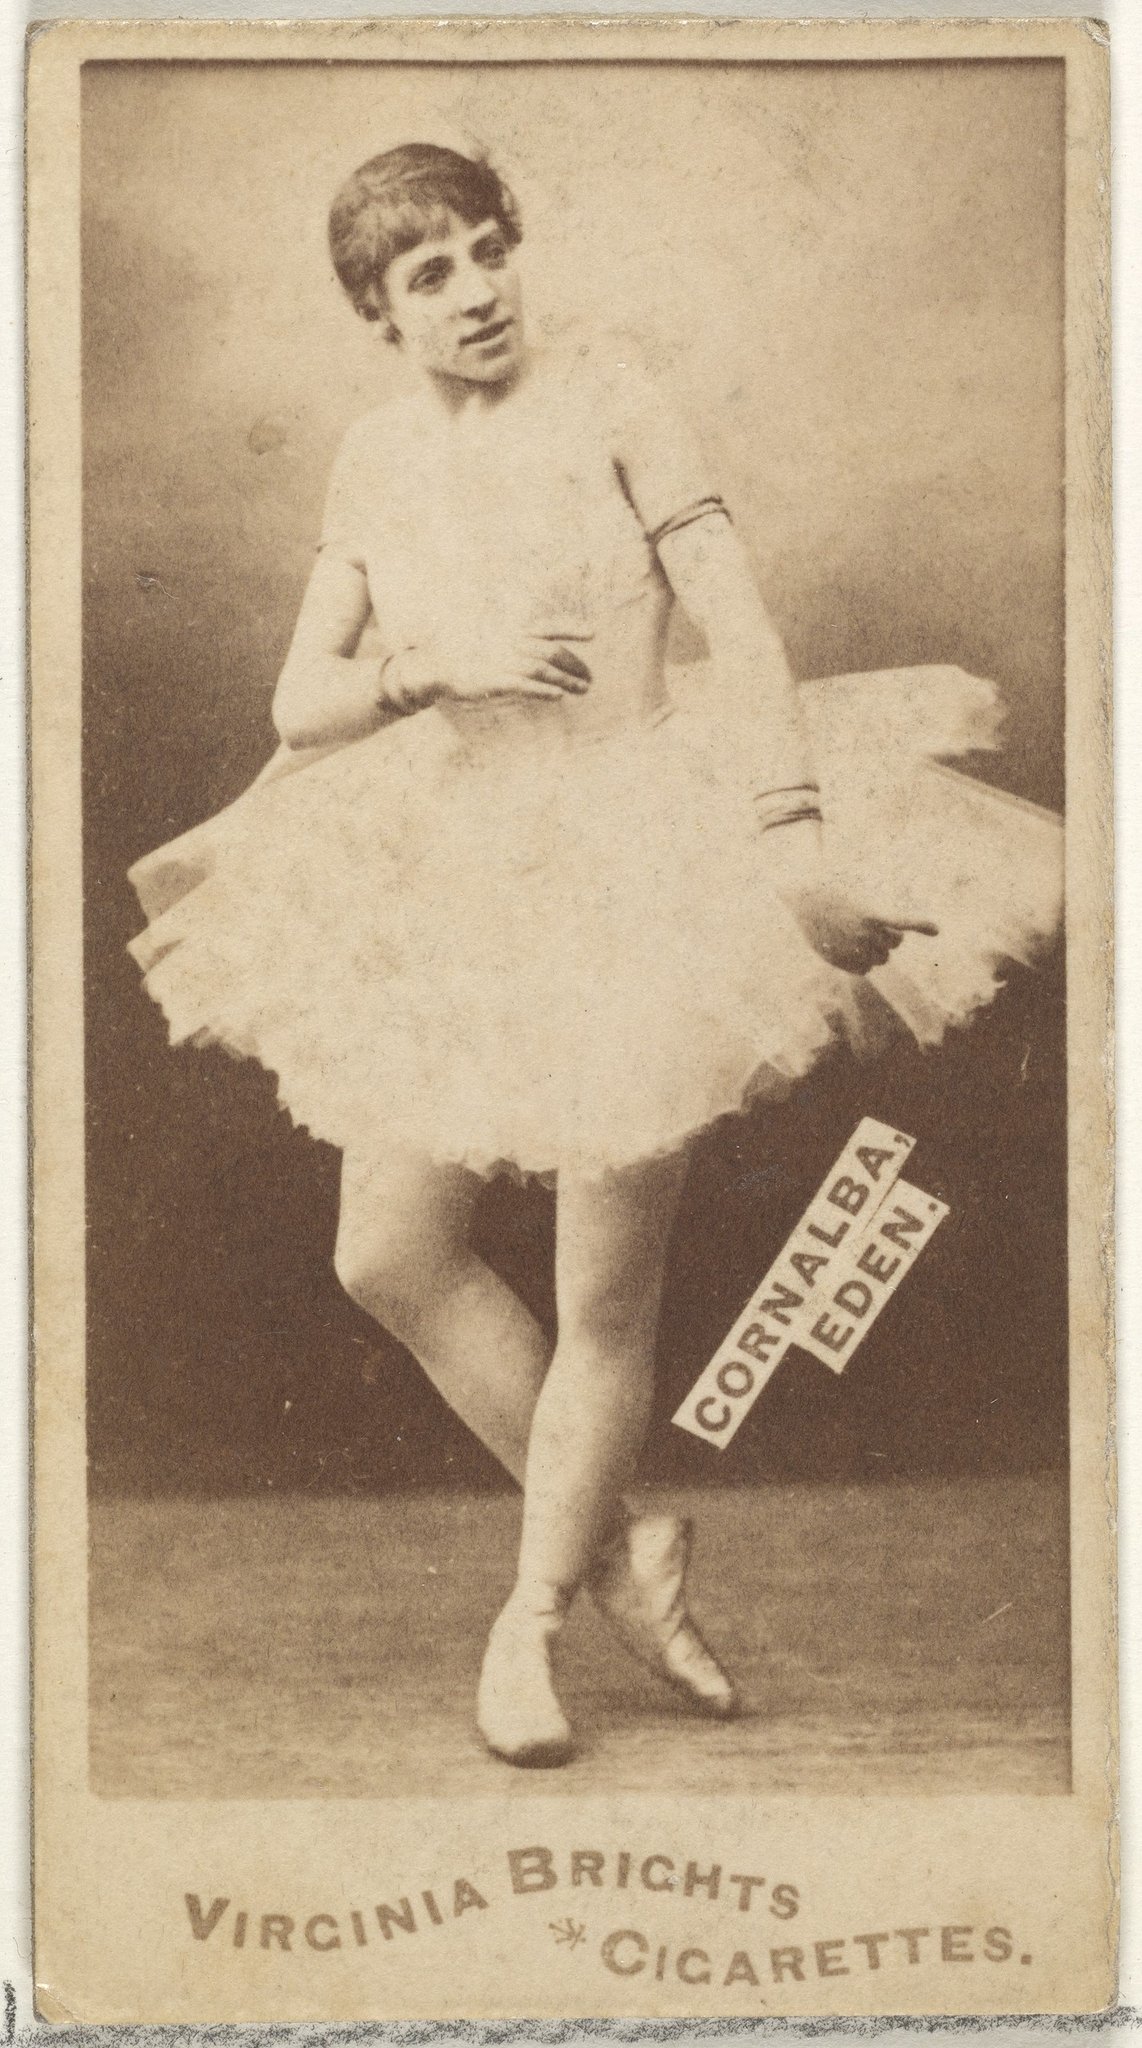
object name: photograph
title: Cornalba, Eden, from the Actors and Actresses series (N45, Type 1) for Virginia Brights Cigarettes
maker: allen & ginter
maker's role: publisher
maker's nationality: american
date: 1888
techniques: albumen silver print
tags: portraits,women,dancers,ballet